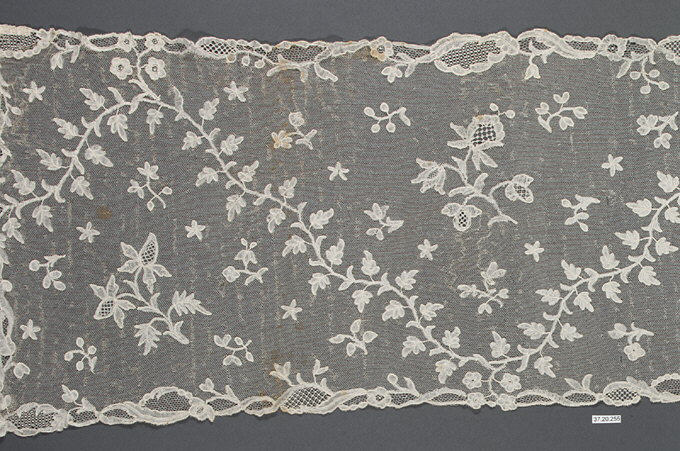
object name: border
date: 1701-1800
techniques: lace